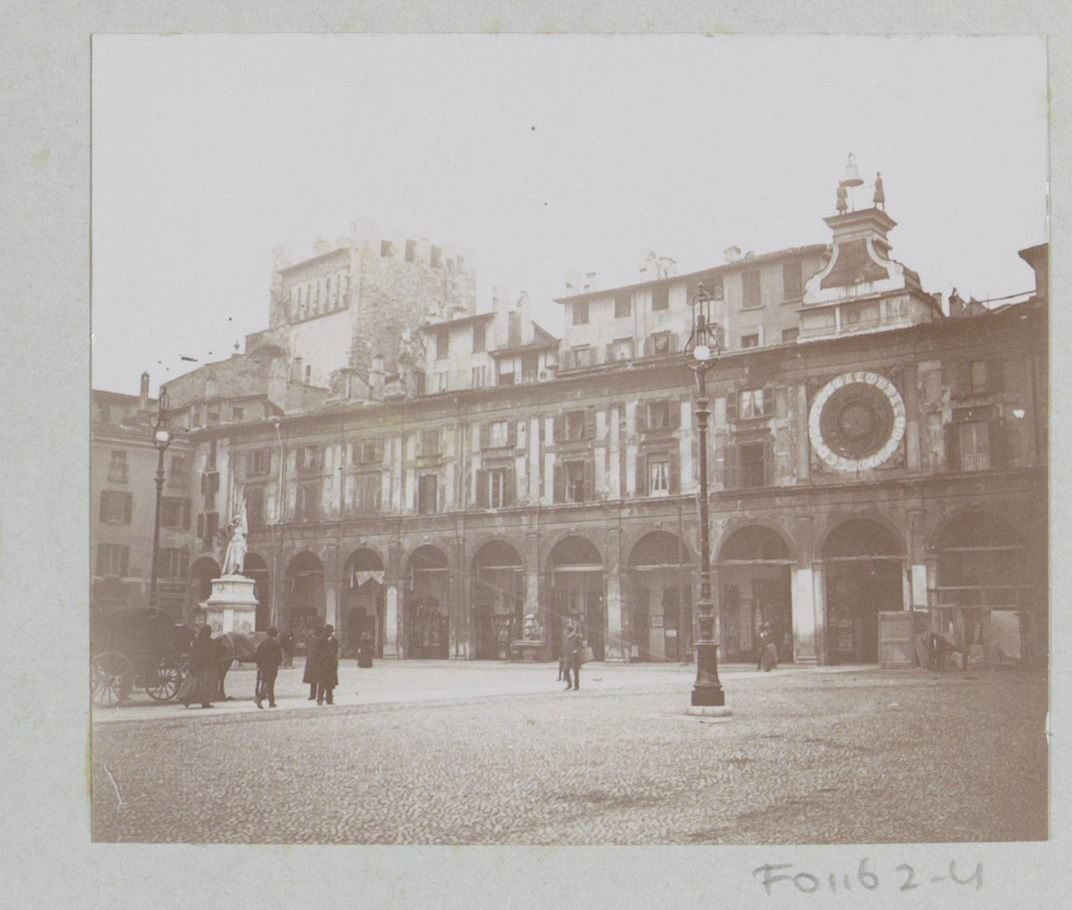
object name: photograph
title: Piazza del Mercato in Brescia met rechts de klokkentoren (Torre dell'Orologio)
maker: Anonymous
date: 1905-1910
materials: paper, photographic support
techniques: gelatin silver print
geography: brescia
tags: tower, clock tower ~ monumental adornment, square, place, circus, etc. (+ city(-scape) with figures, staffage)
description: Onderdeel van Fotoalbum van een Franse amateurfotograaf met bezienswaardigheden in Frankrijk, Zwitserland en Italië.